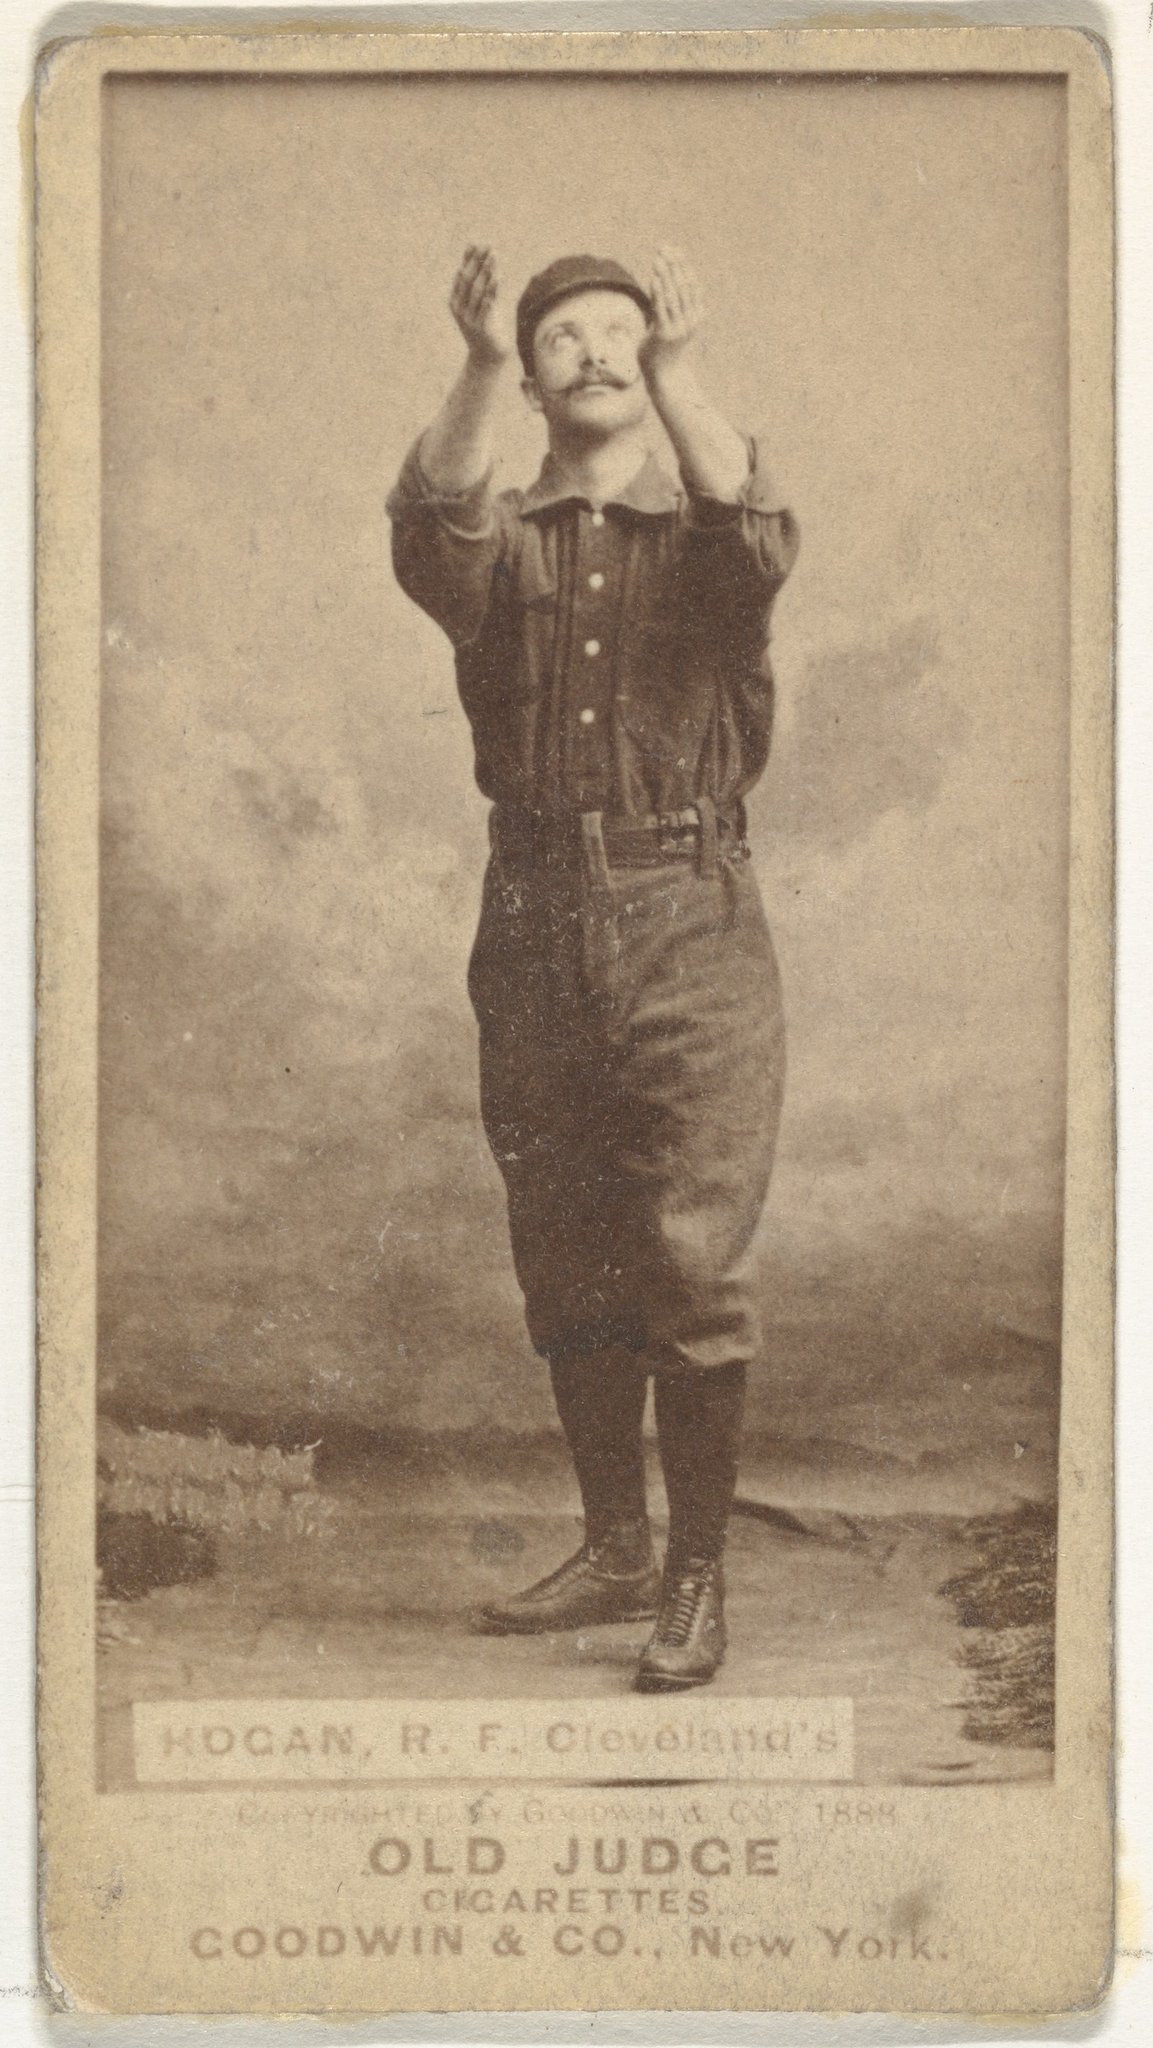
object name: baseball card, photograph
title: Mortimer Edward Hogan, Right Field, Cleveland, from the Old Judge series (N172) for Old Judge Cigarettes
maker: goodwin & company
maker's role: publisher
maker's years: 1850-1950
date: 1888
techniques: albumen silver print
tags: men,portraits,baseball,athletes